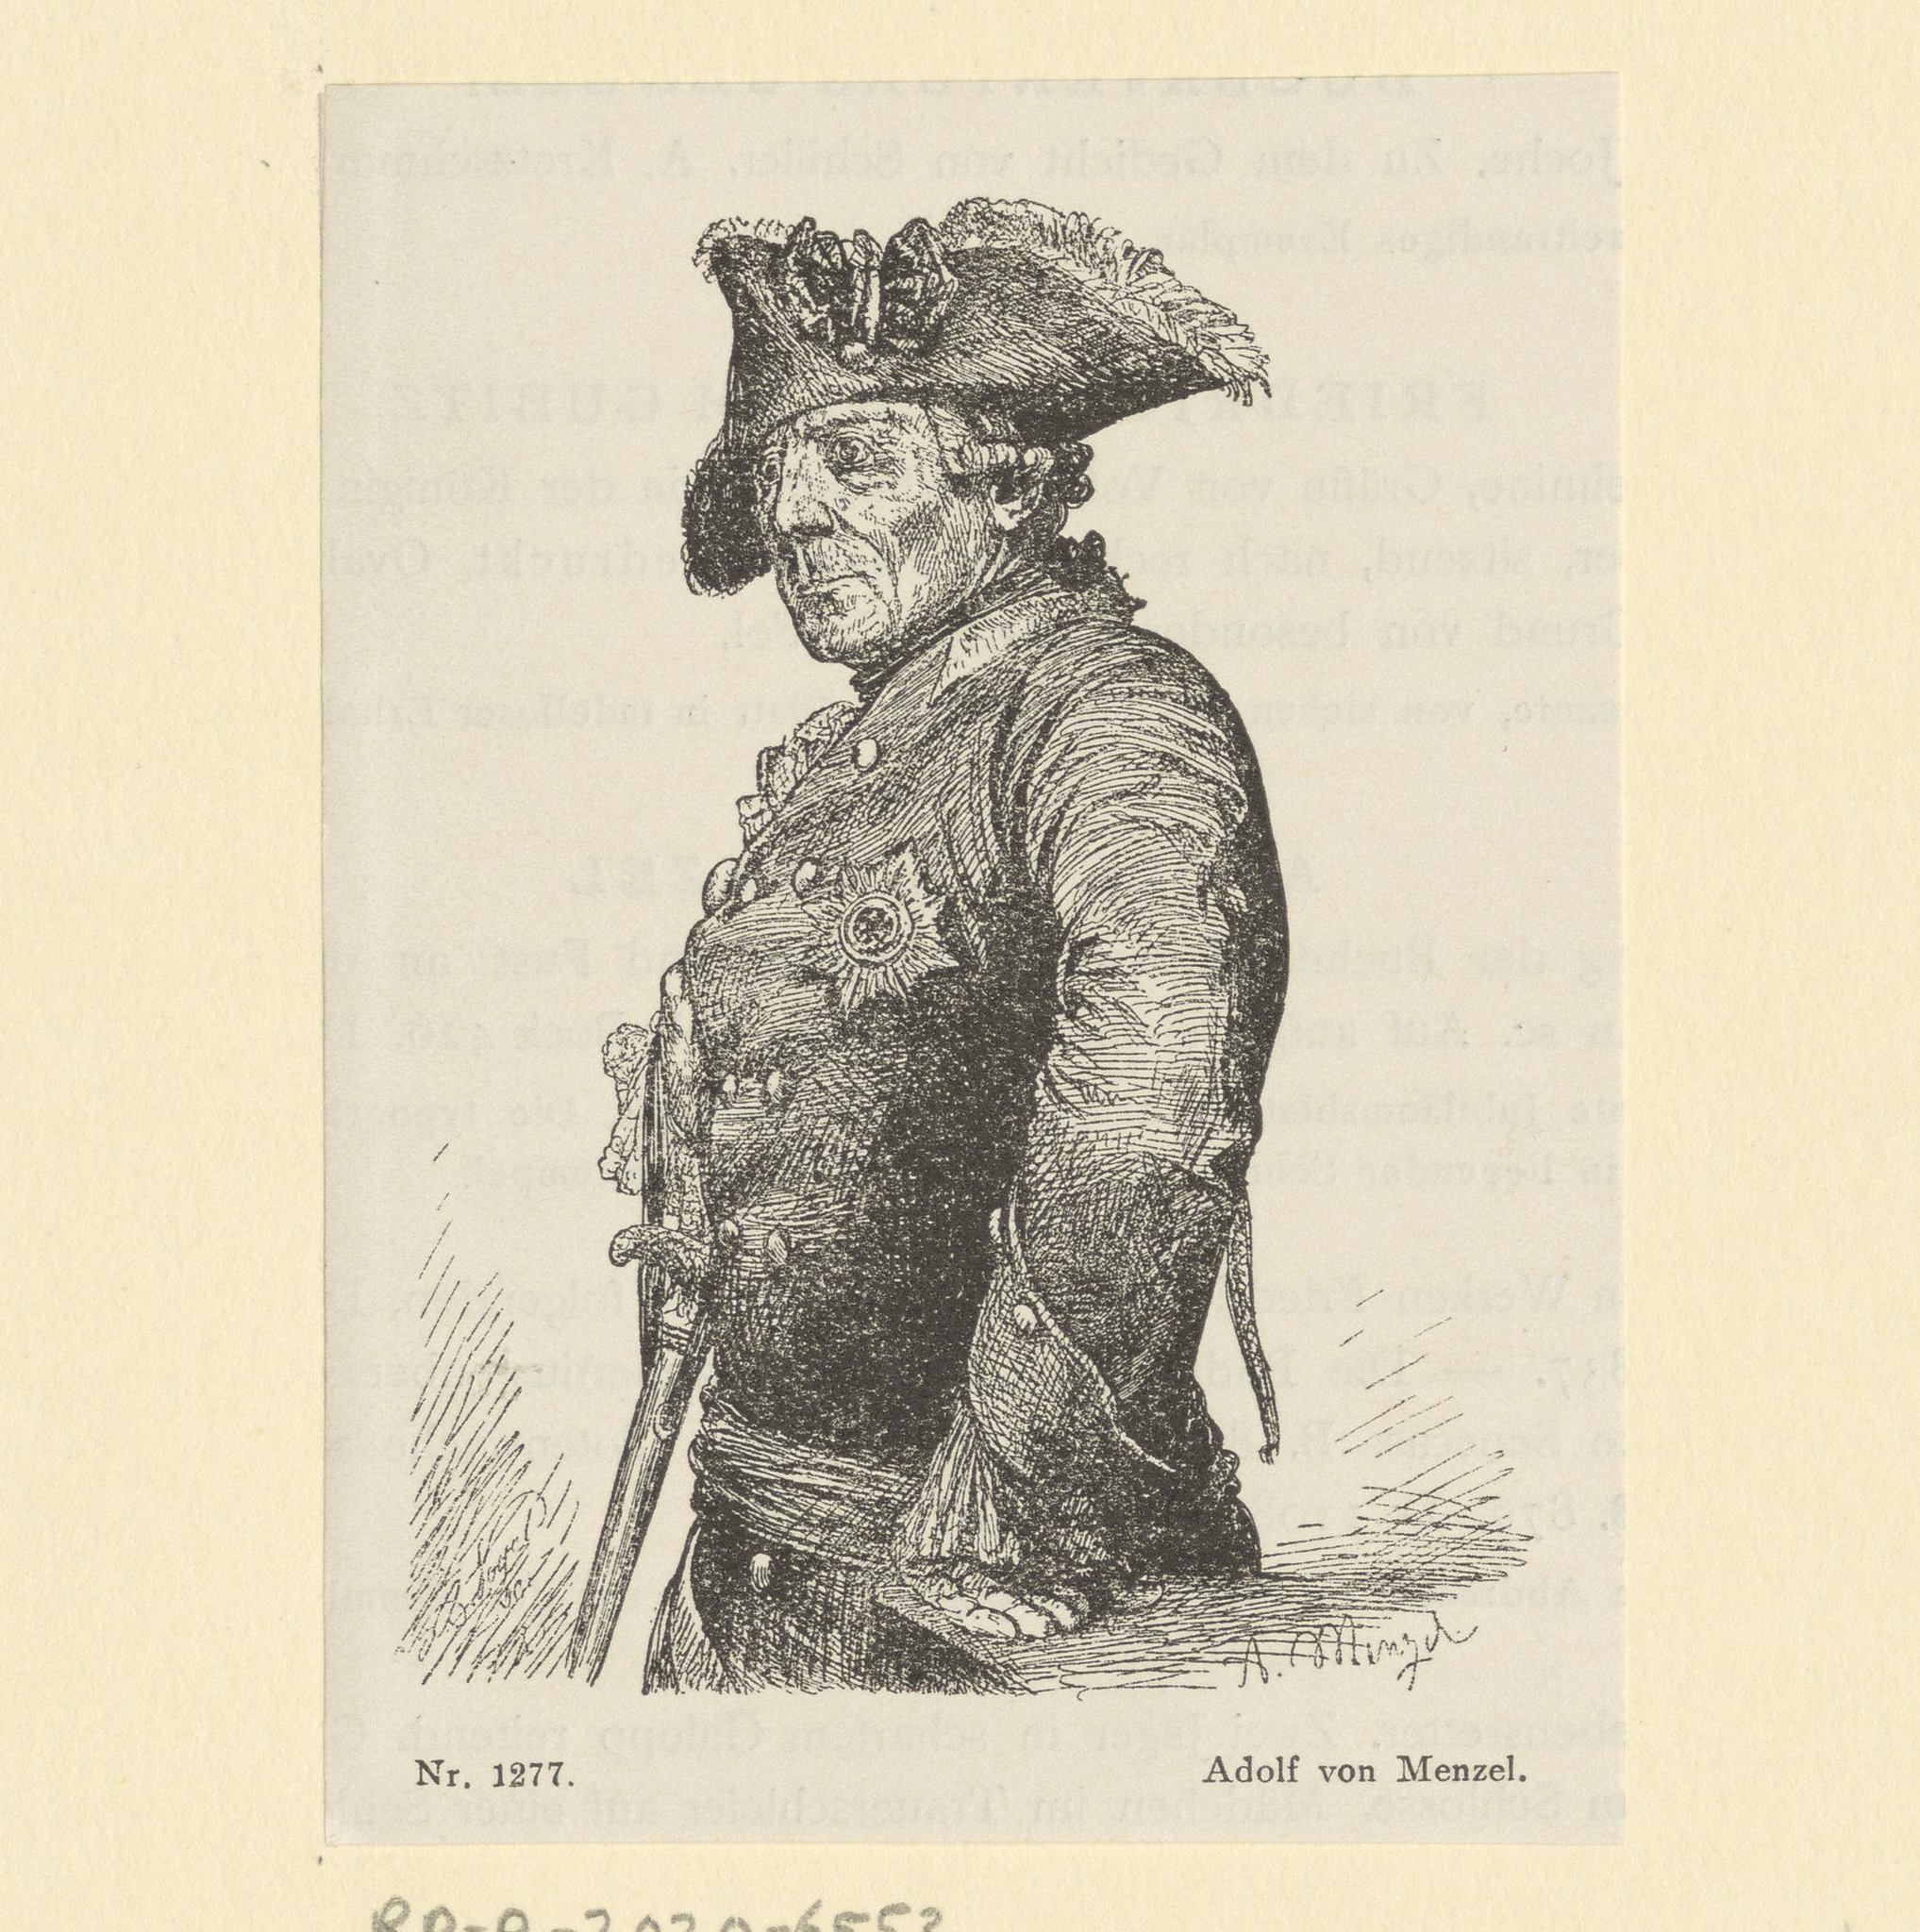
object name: photomechanical print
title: Portret van Frederik de Grote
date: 1875-1930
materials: paper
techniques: photograph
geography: germany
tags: frederick ii (king of prussia), historical persons, king